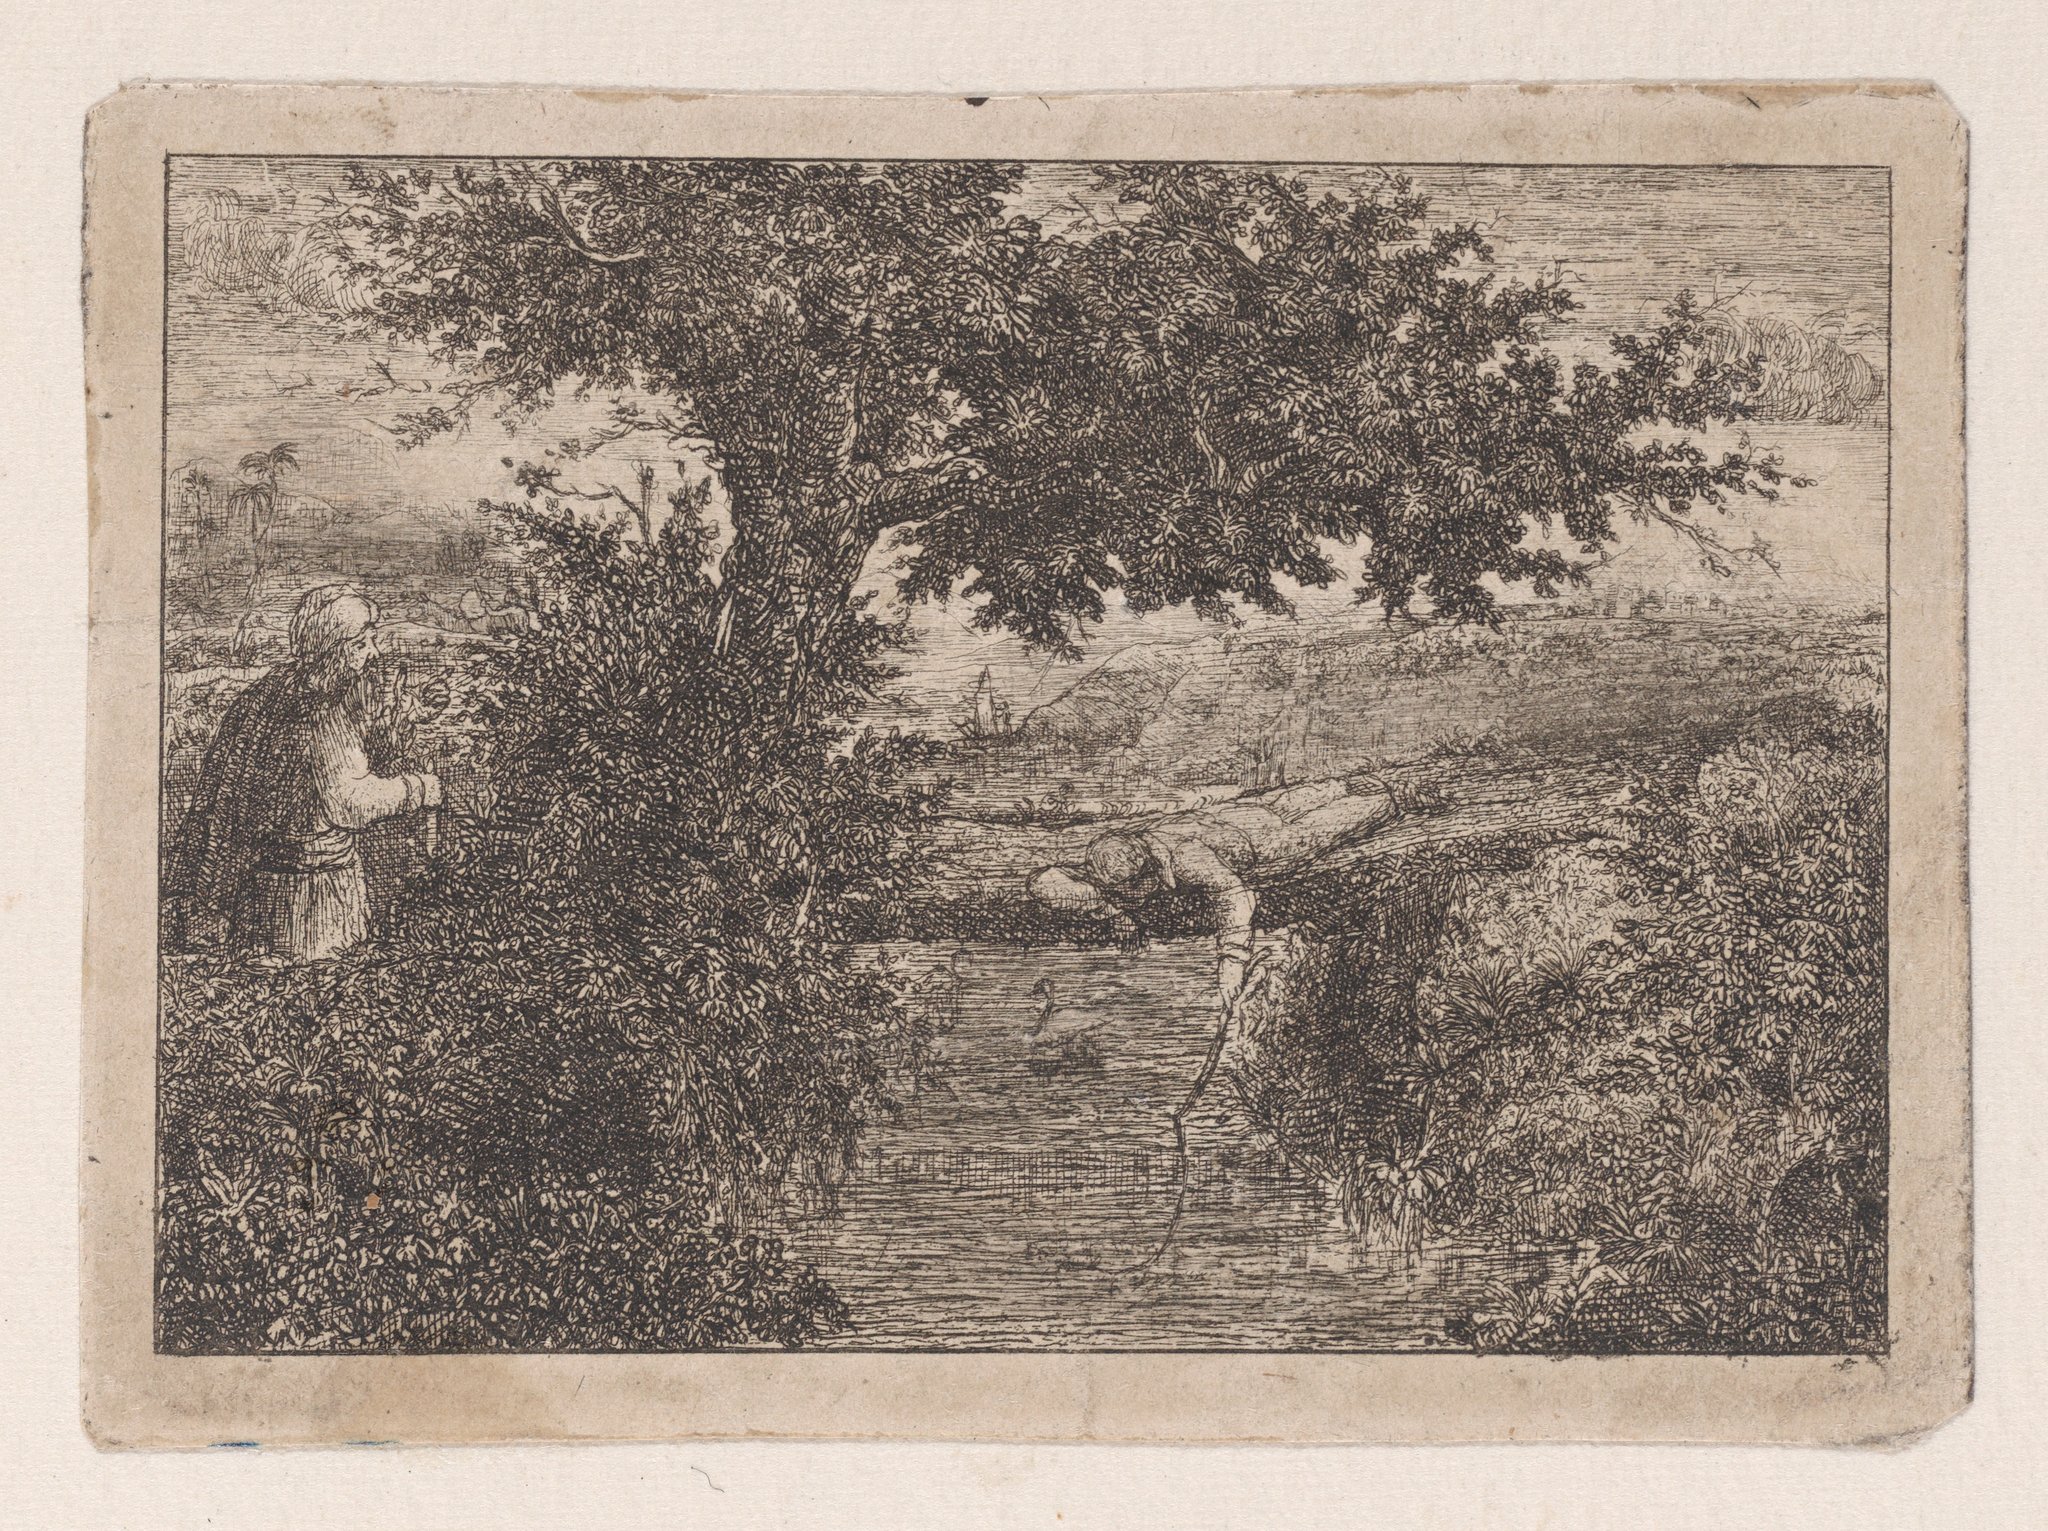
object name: print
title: Scène Biblique (Biblical Scene)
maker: rodolphe bresdin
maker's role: artist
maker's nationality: french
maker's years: 1822-1885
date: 1801-1900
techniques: etching